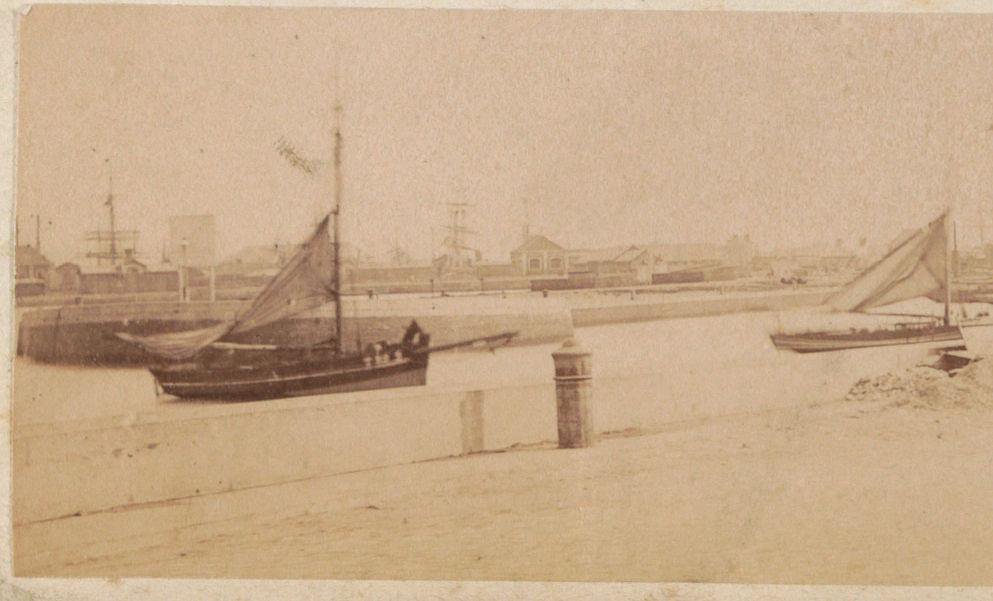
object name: photograph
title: Gezicht op een havenkade en zeilschepen in Frankrijk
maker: Anonymous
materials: photographic support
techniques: albumen print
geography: france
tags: harbour (+ view ~ vehicle, ship, etc.), france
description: Onderdeel van Album van een Franse amateurfotograaf met opnames van familie, militairen, industrie, landschappen en bezienswaardigheden in Frankrijk.